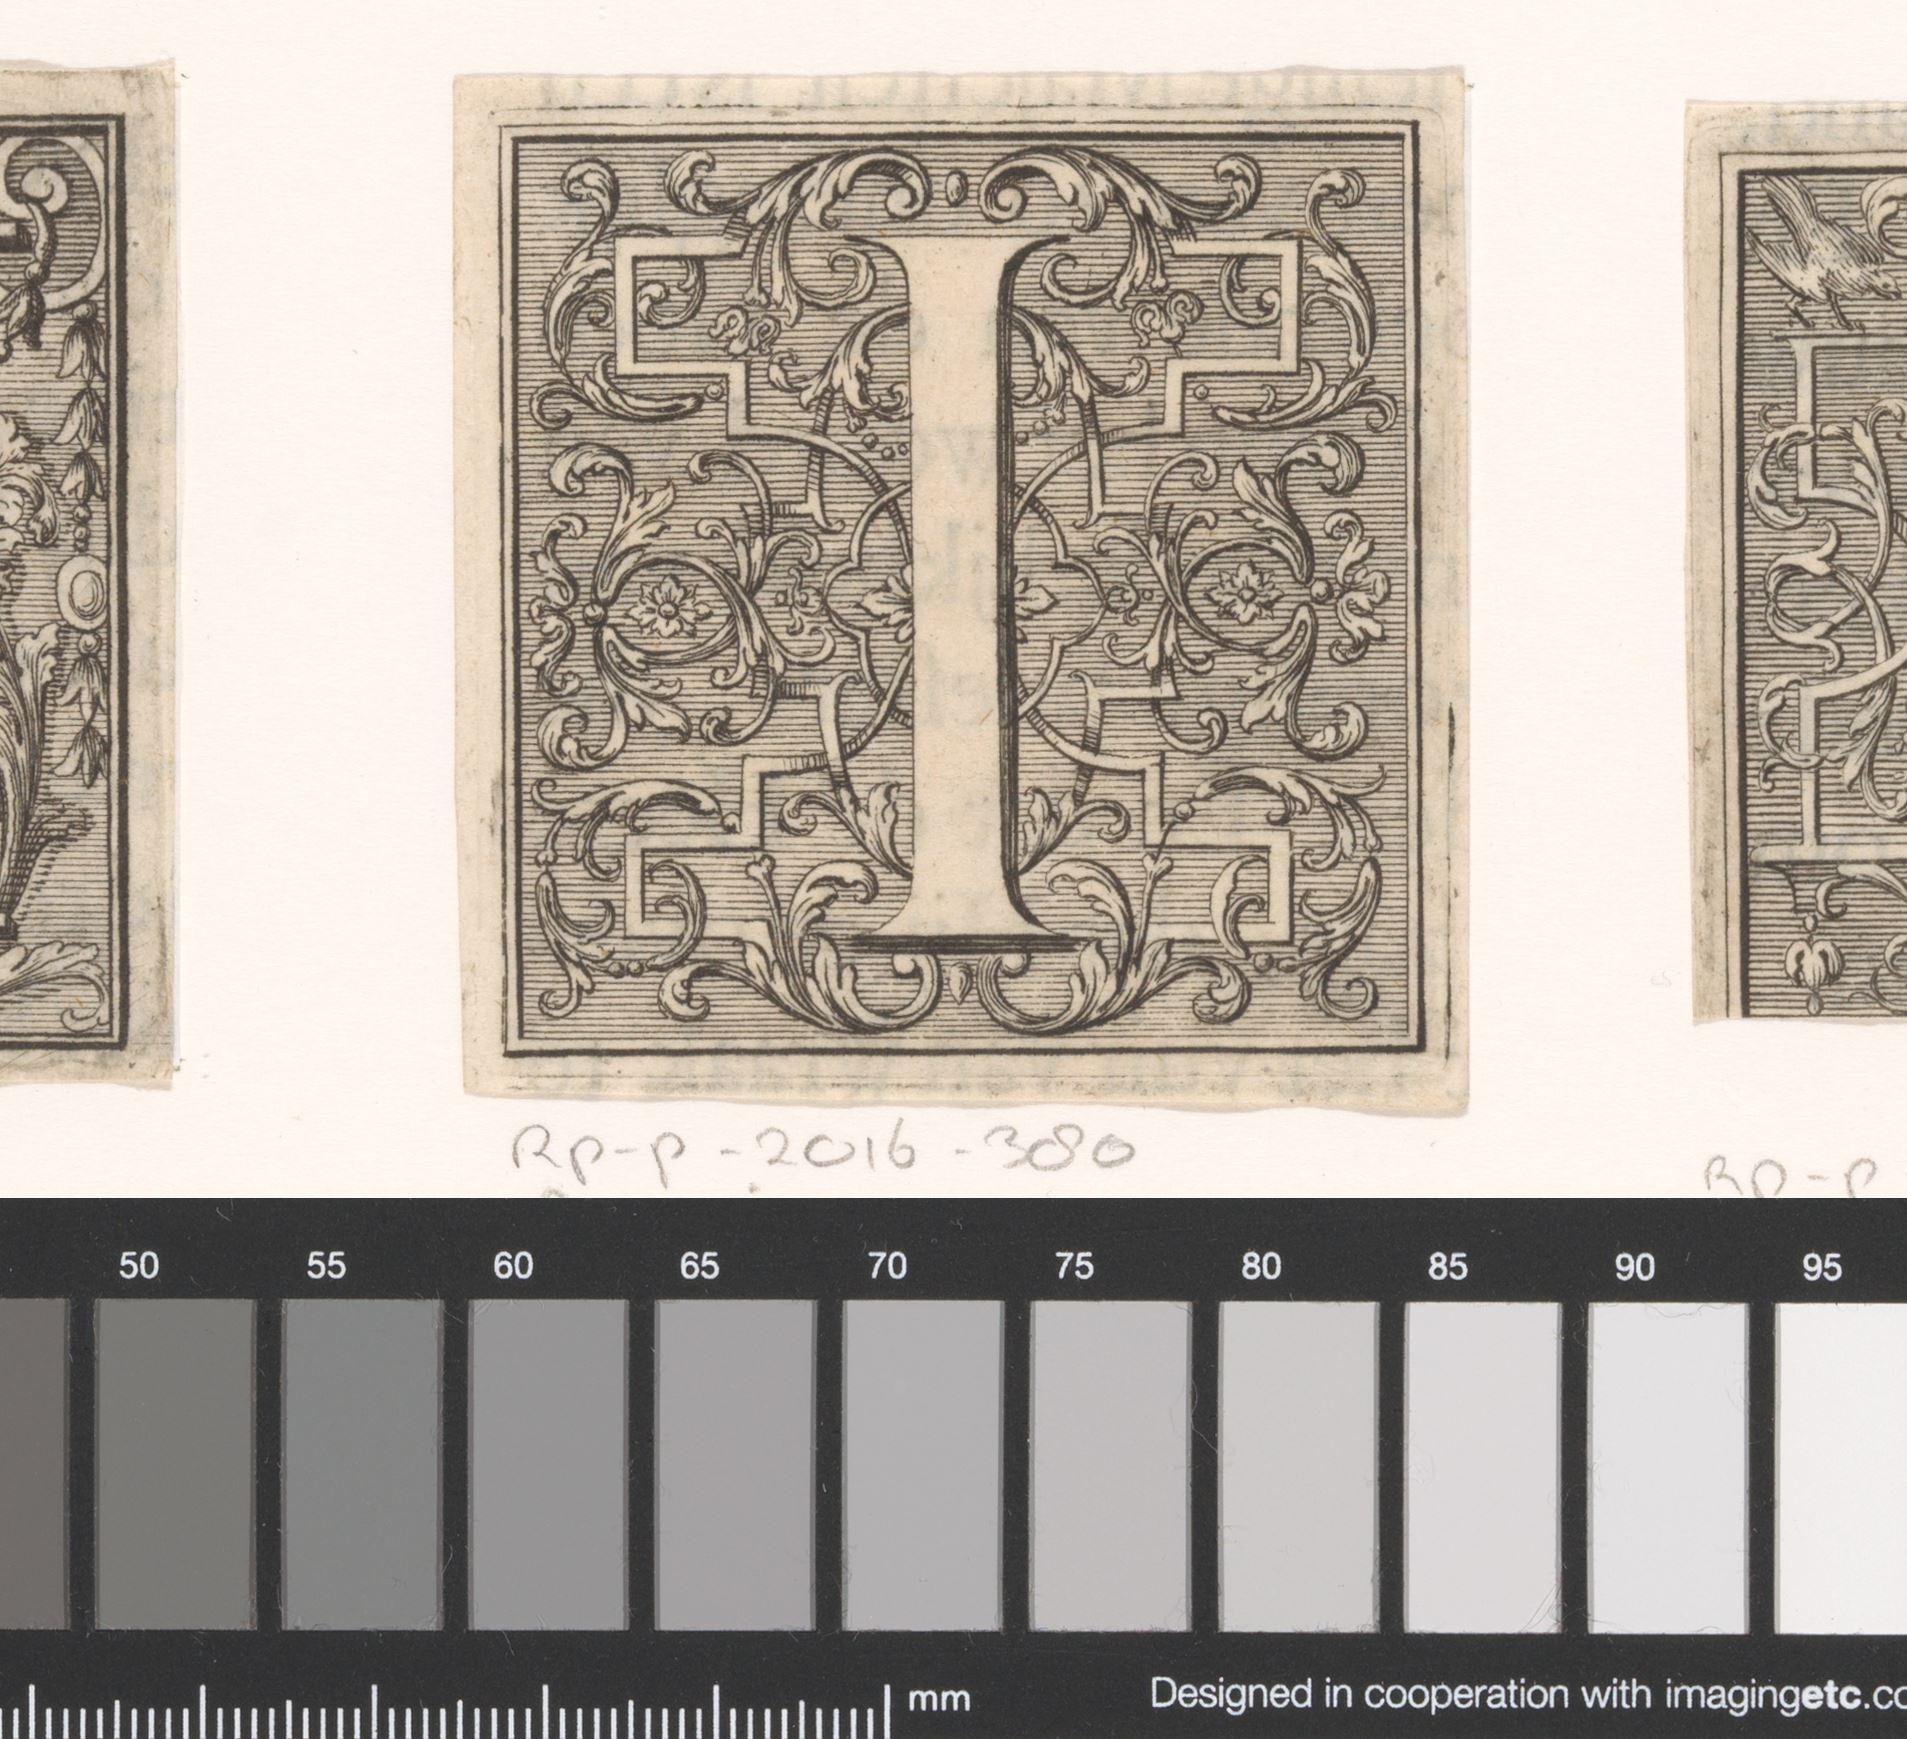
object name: print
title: Letter I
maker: Anonymous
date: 1700-1799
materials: paper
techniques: etching, letterpress printing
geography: netherlands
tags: fancy letters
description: Letter I tegen een achtergrond met vlechtwerk.